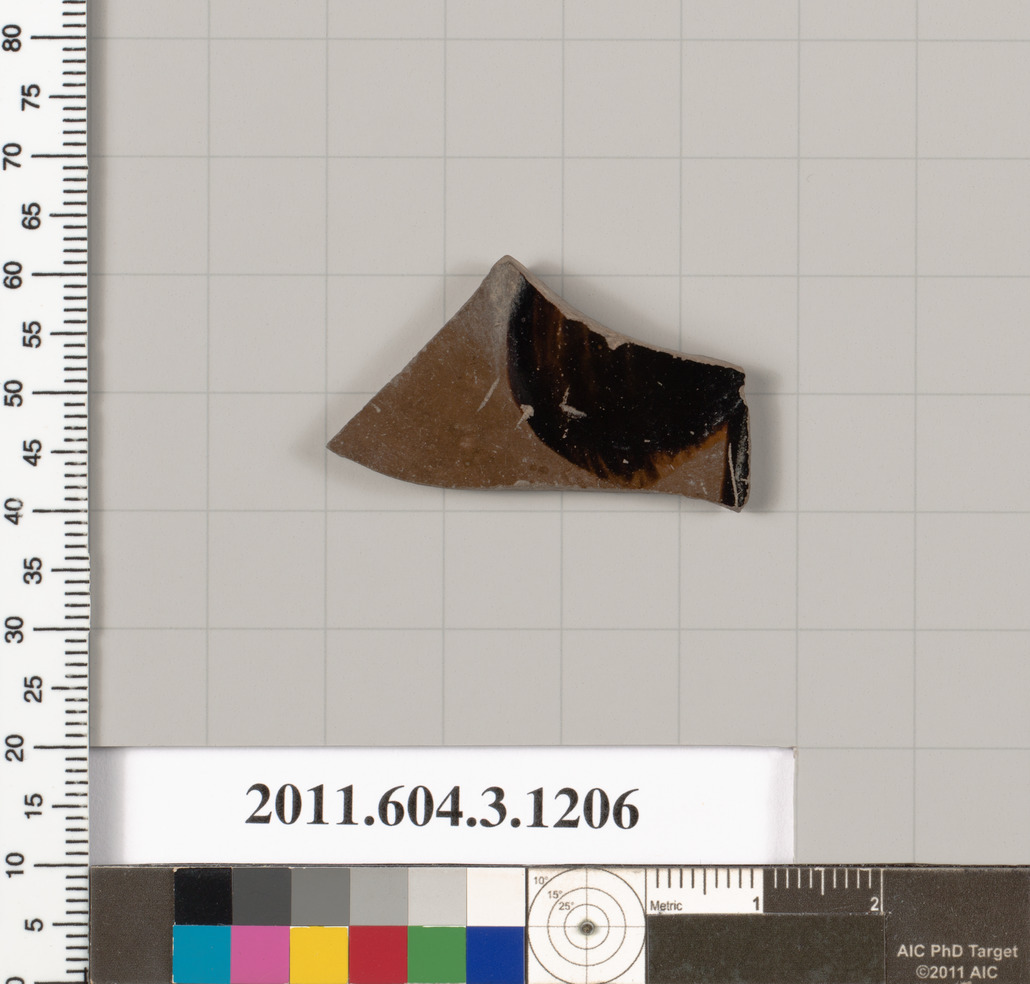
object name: mastoid fragment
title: Terracotta fragment of a mastoid (drinking cup with narrow base) ?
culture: greek, attic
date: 534-468 BCE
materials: terracotta